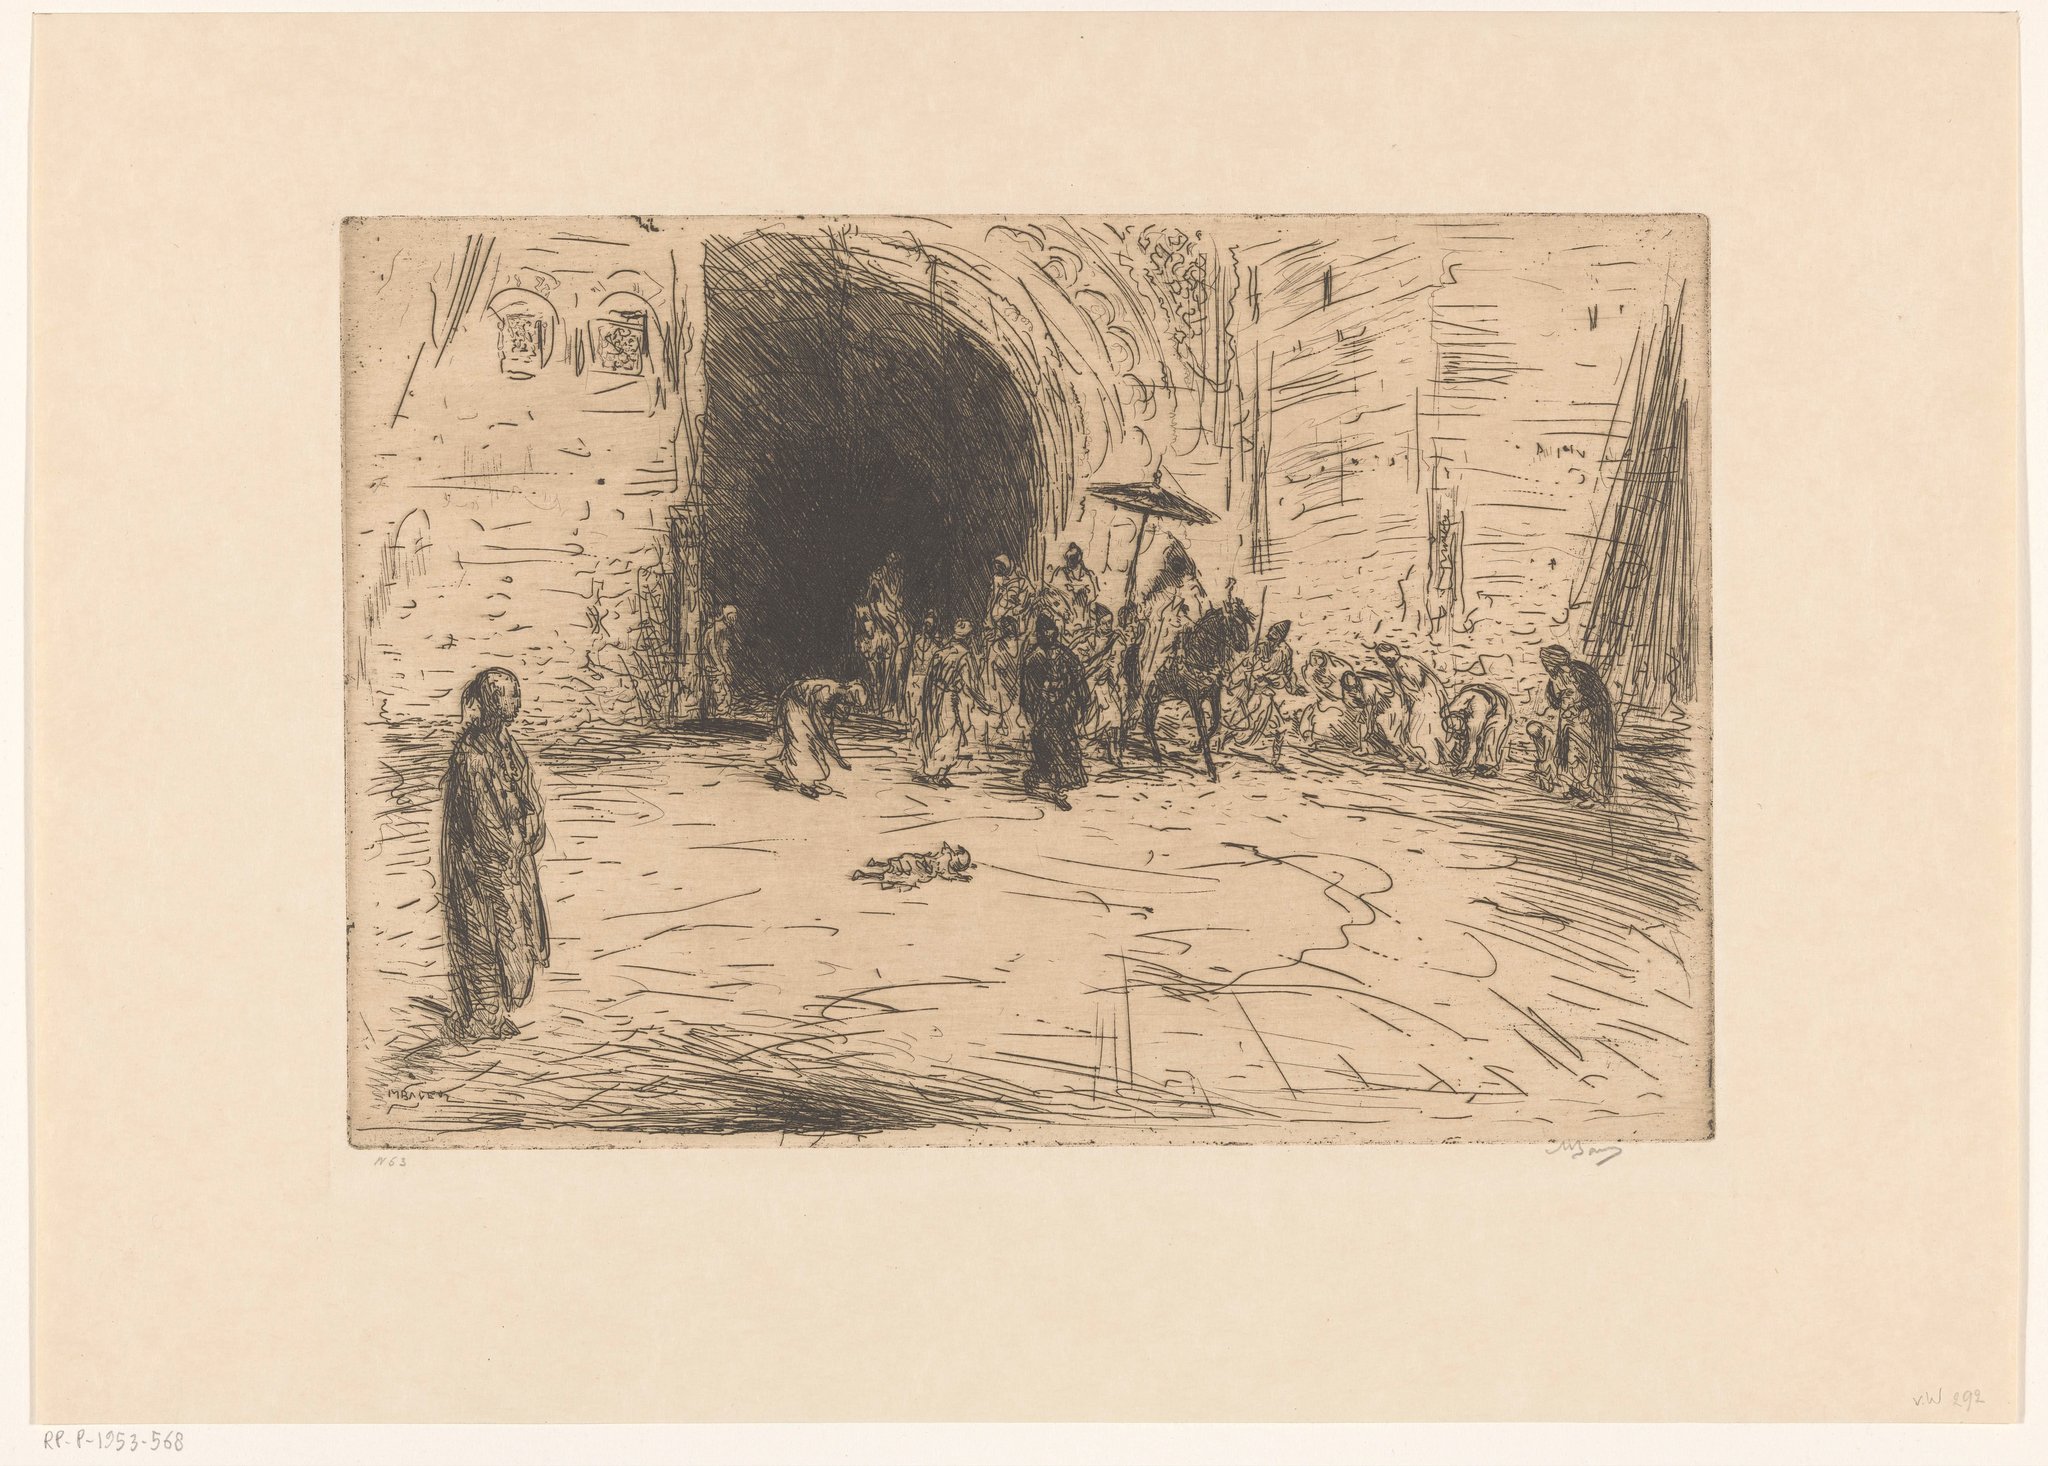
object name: print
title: Sultan met gevolg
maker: marius bauer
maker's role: draughtsman, print maker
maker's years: 1867-1932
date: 1930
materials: paper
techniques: etching, intaglio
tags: riding a horse, ass, or mule; rider, horseman, contrast between important and unimportant people; the inferior before the superior, the weak before the mighty, parasol, sunshade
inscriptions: collector's mark: Lugt 2228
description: Een man gezeten op een paard wordt een parasol boven het hoofd gehouden. Om hem heen andere mannen te paard, wachters en knielende figuren.